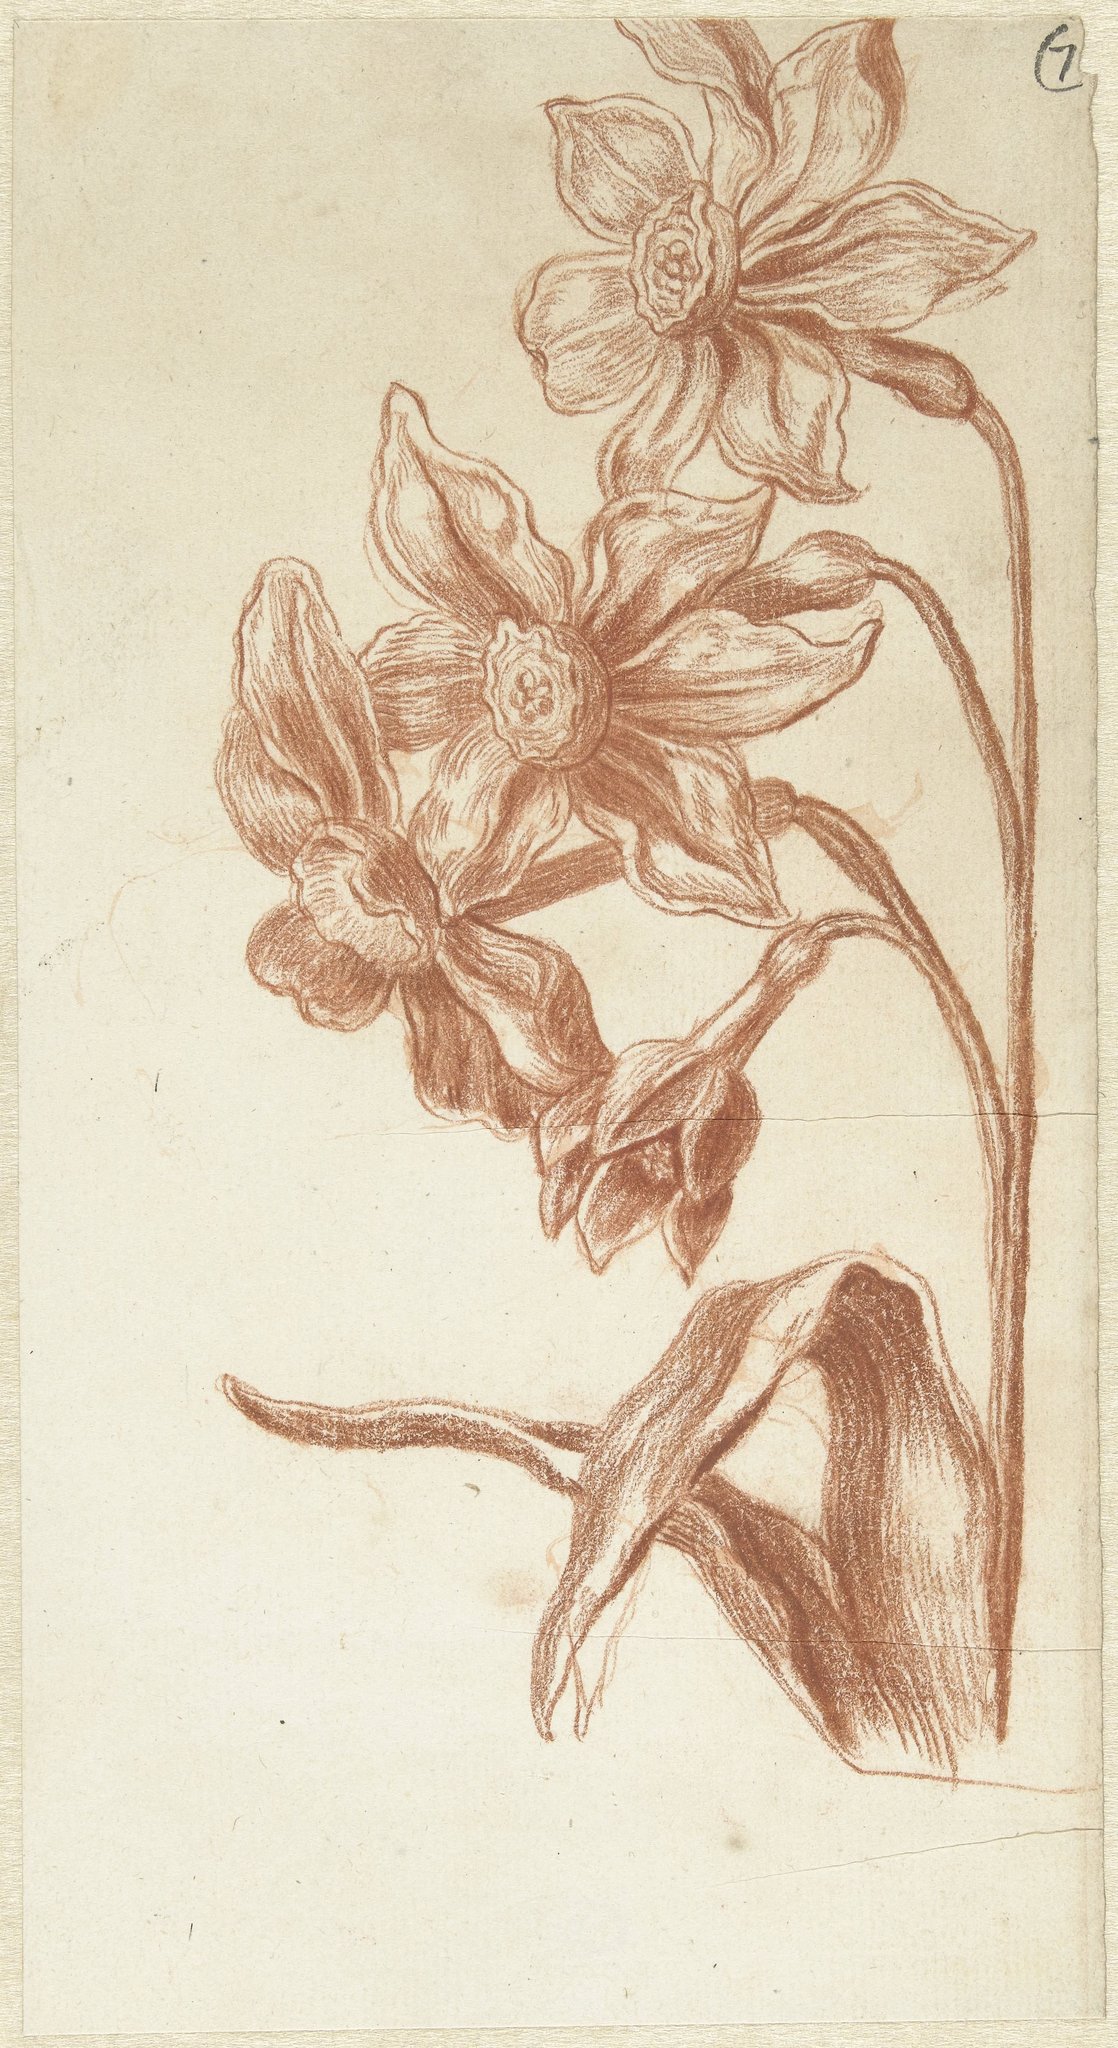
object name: drawing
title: Narcissen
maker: bernard picart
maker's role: draughtsman, print maker, publisher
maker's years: 1673-1733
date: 1683-1733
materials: chalk, paper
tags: flowers: daffodil